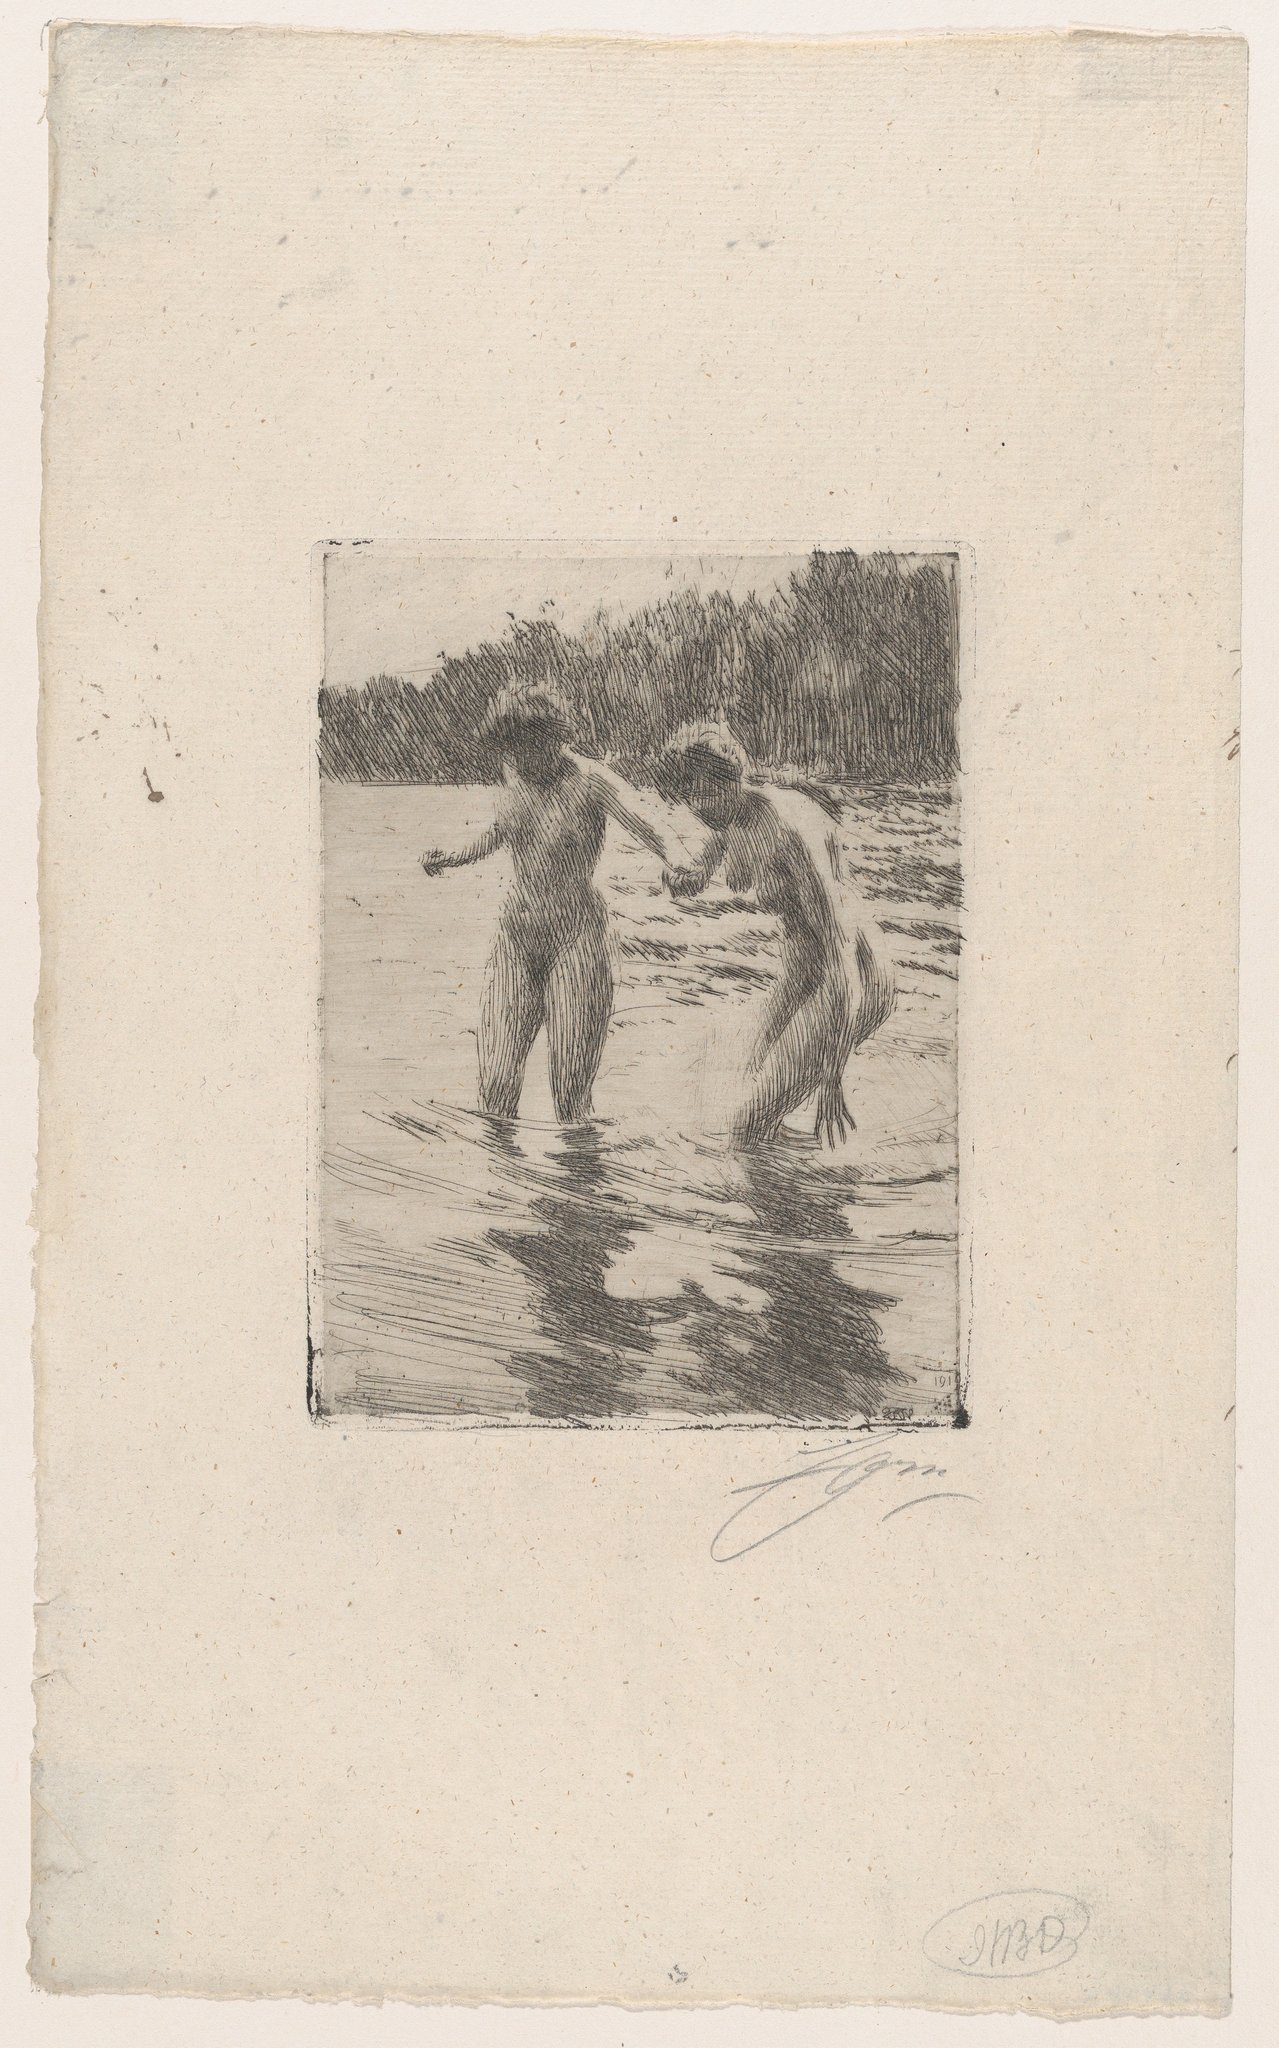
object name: print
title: Two Bathers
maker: anders zorn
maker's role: artist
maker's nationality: swedish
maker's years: 1860-1920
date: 1910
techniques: etching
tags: female nudes,bathing